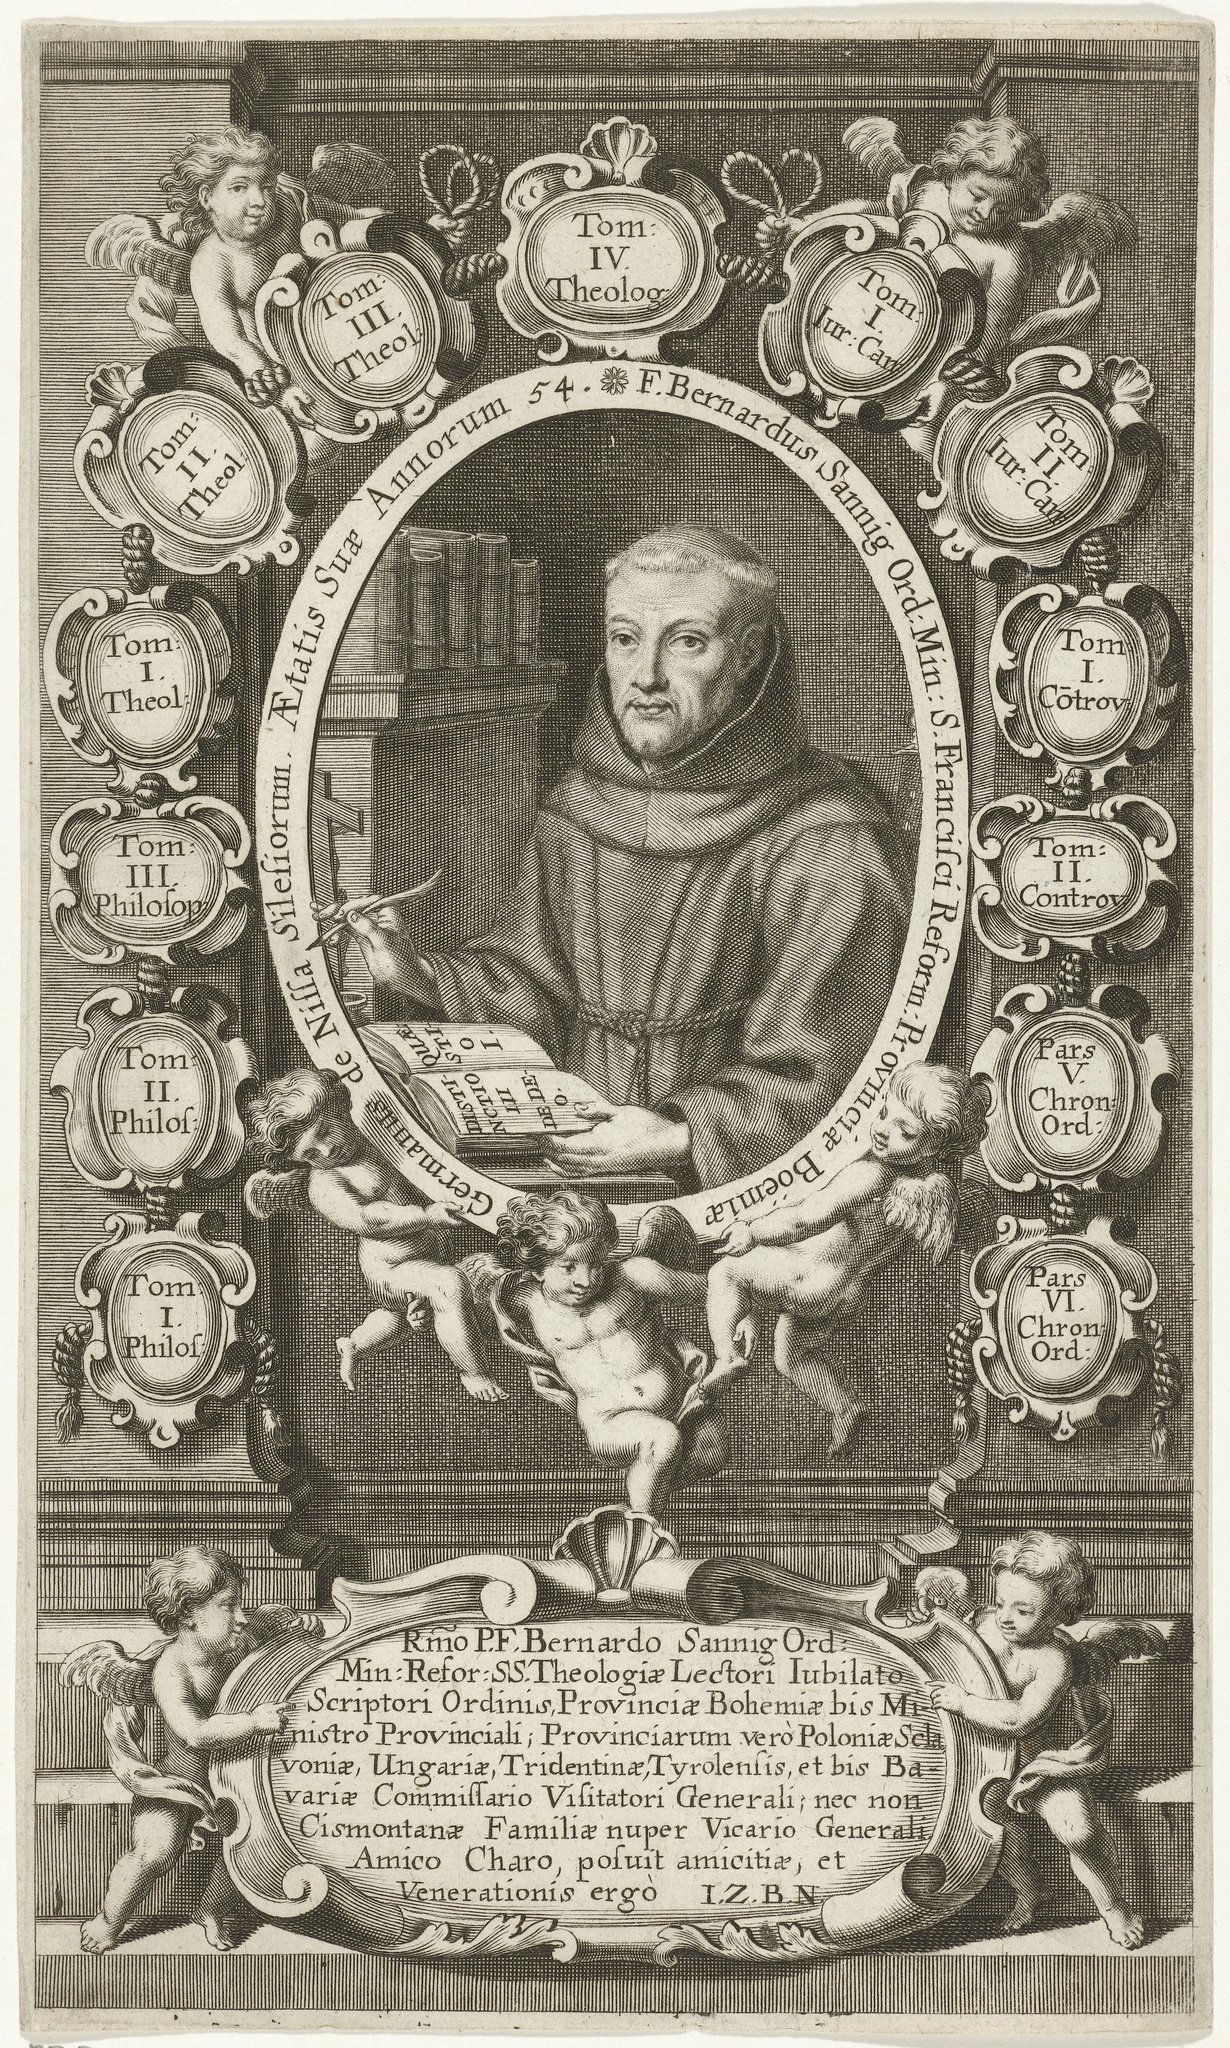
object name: print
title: Portret van Bernhard Sannig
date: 1660-1730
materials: paper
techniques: engraving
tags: ornament ~ cartouche, angels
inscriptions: collector's mark: Lugt 2228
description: Portret van Bernhard Sannig gekleed in pij, in zijn rechterhand een schrijfveer, zittend aan een tafel met een boek. Portret gevat in een ovaal dat aan de onderzijde wordt ondersteund door drie engelen en is omlijst met schilden waarop de hoofdstukken uit een boek vermeldt staan. Boven nog twee engelen. Onder de voorstelling een door twee engelen geflankeerde omlijsting met negen regels Latijn.